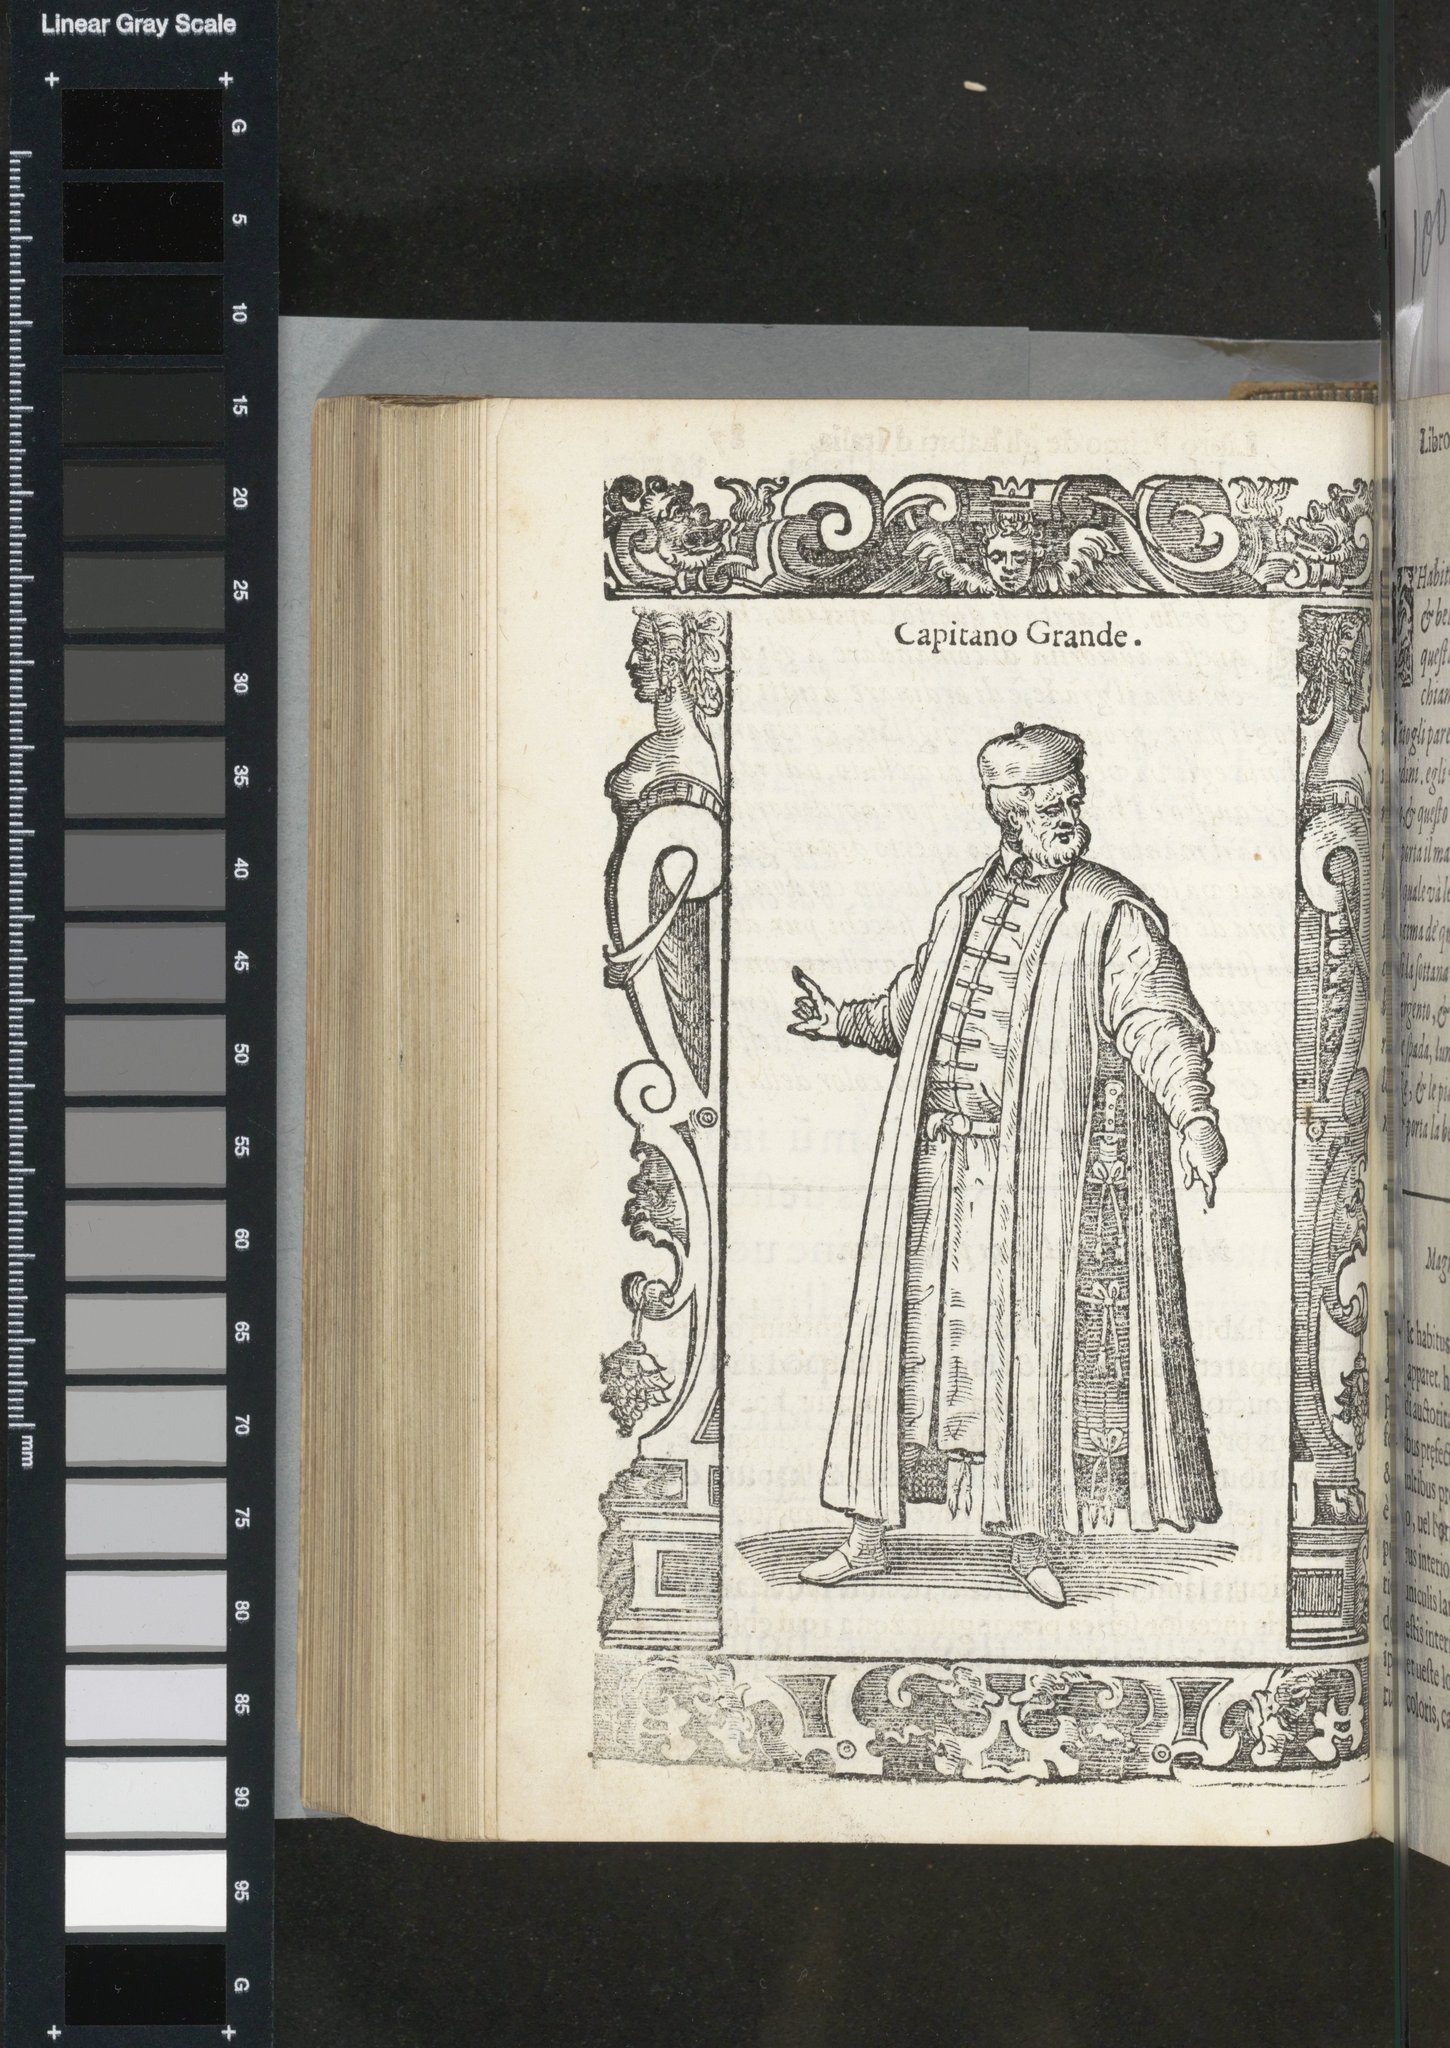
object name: costume print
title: Habiti antichi, et moderni di tutto il mondo..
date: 1598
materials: paper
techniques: woodcut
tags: fashion plates